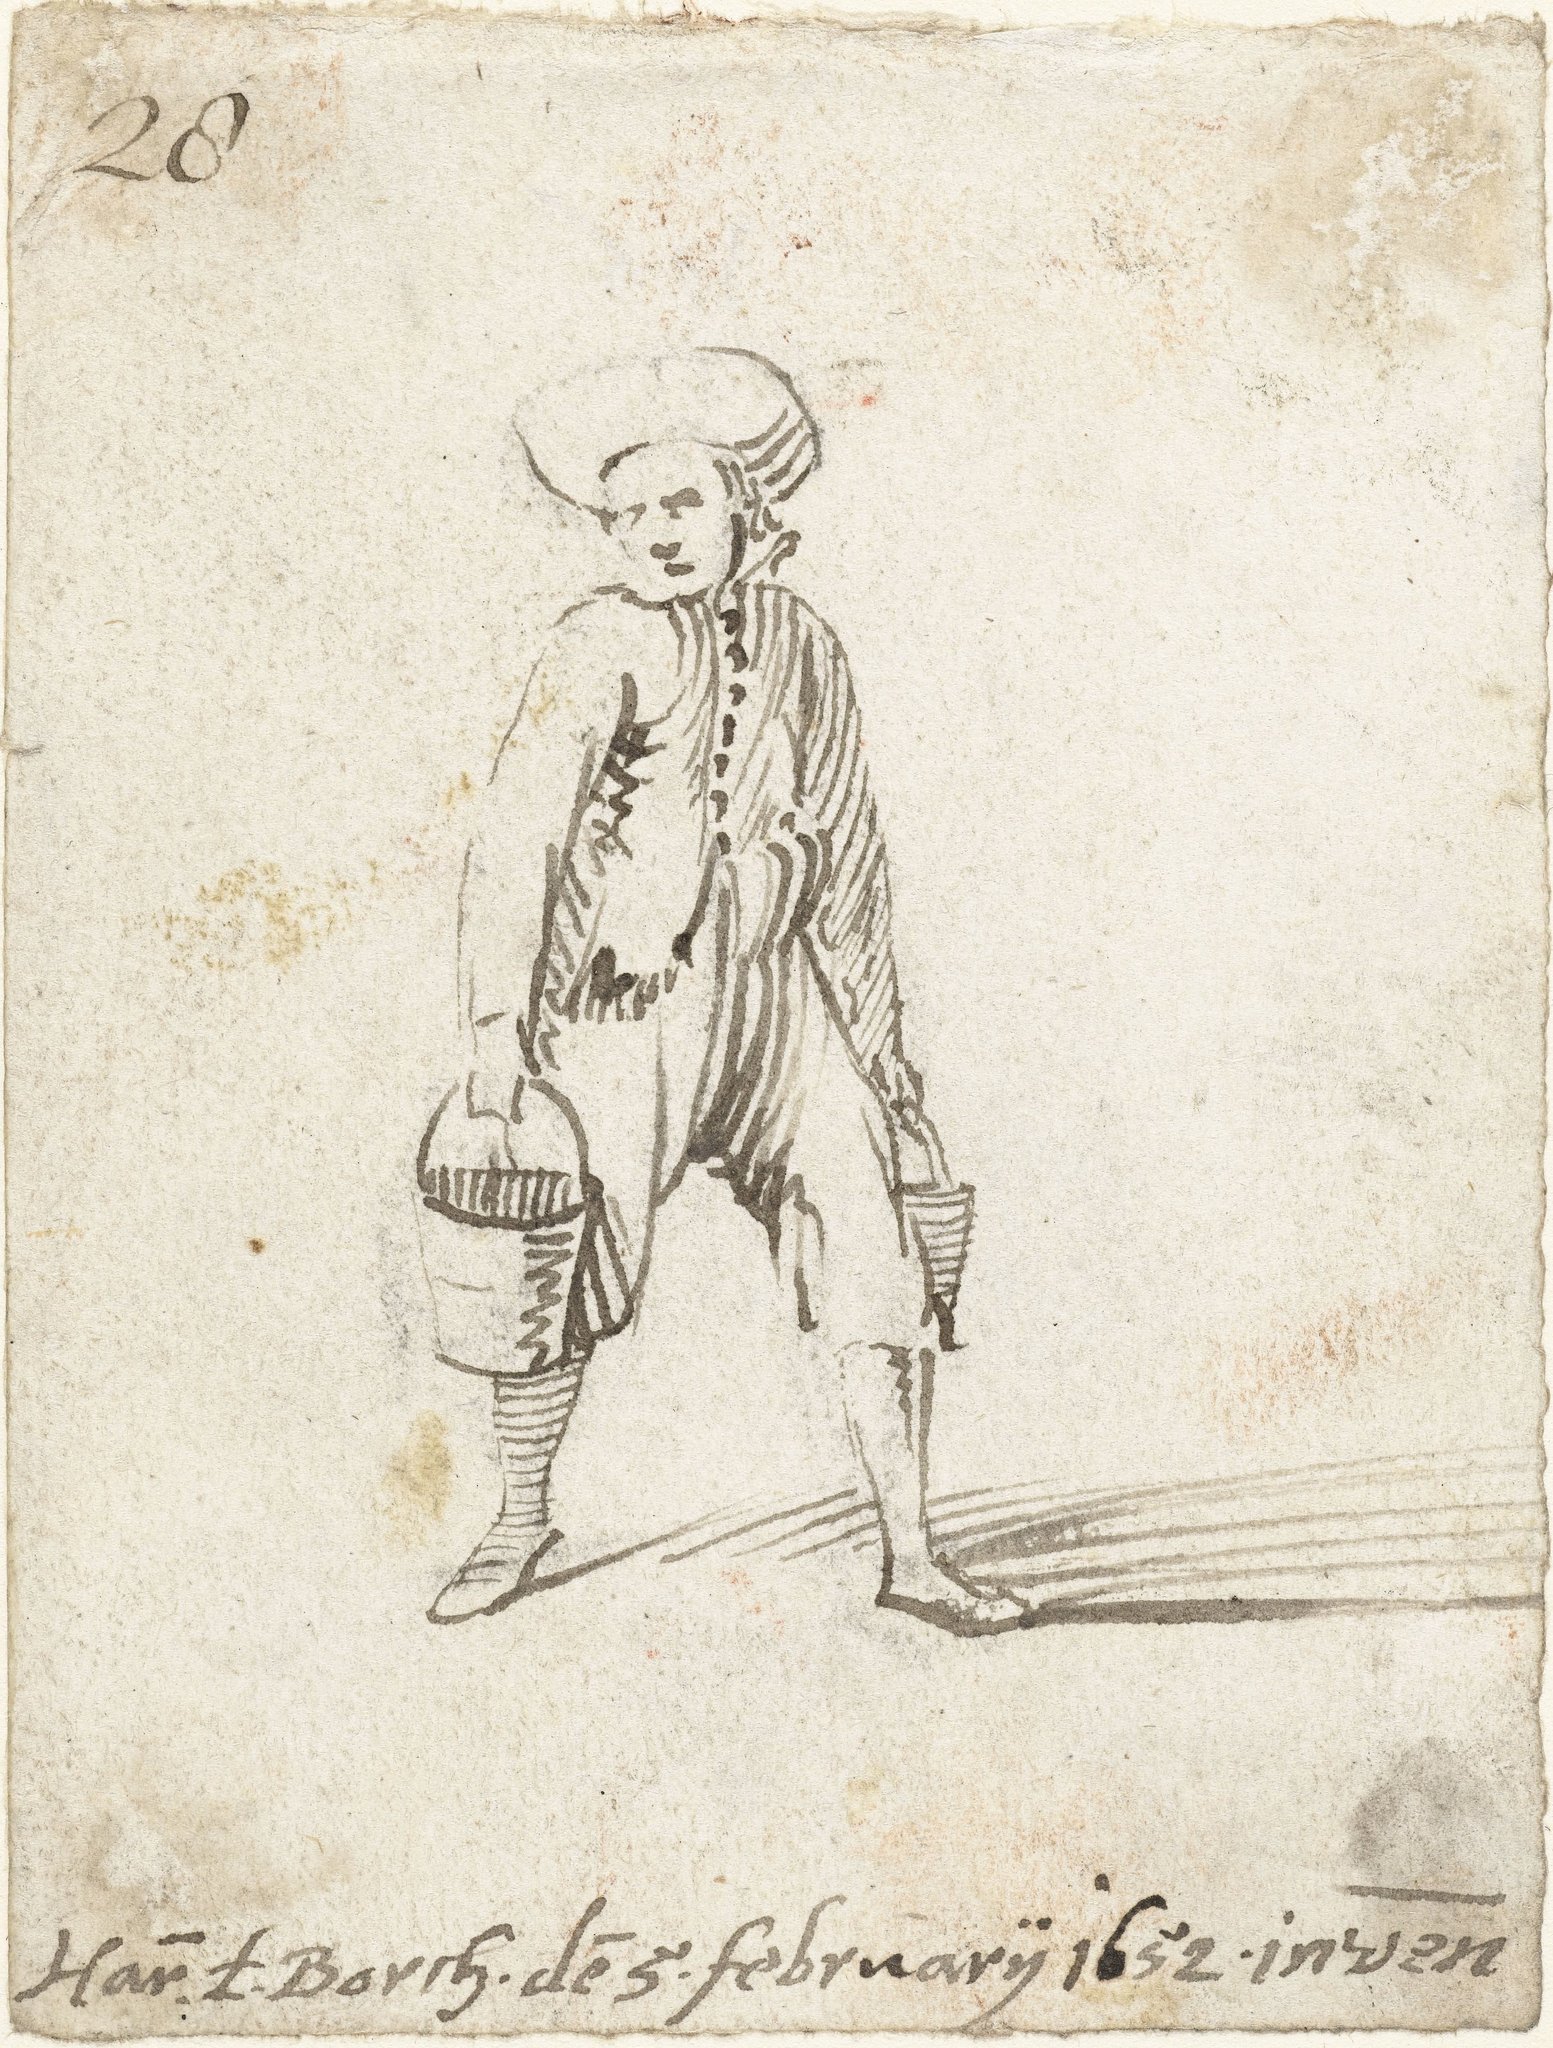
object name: drawing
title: Lopende jongen met een emmer in elke hand, naar rechts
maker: harmen ter borch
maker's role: draughtsman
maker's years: 1638-1677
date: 1652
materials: chalk, ink, paper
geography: zwolle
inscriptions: annotation: ‘Har[man].t.Borch. de[n] 5 februarij 1652. inven[tor]’